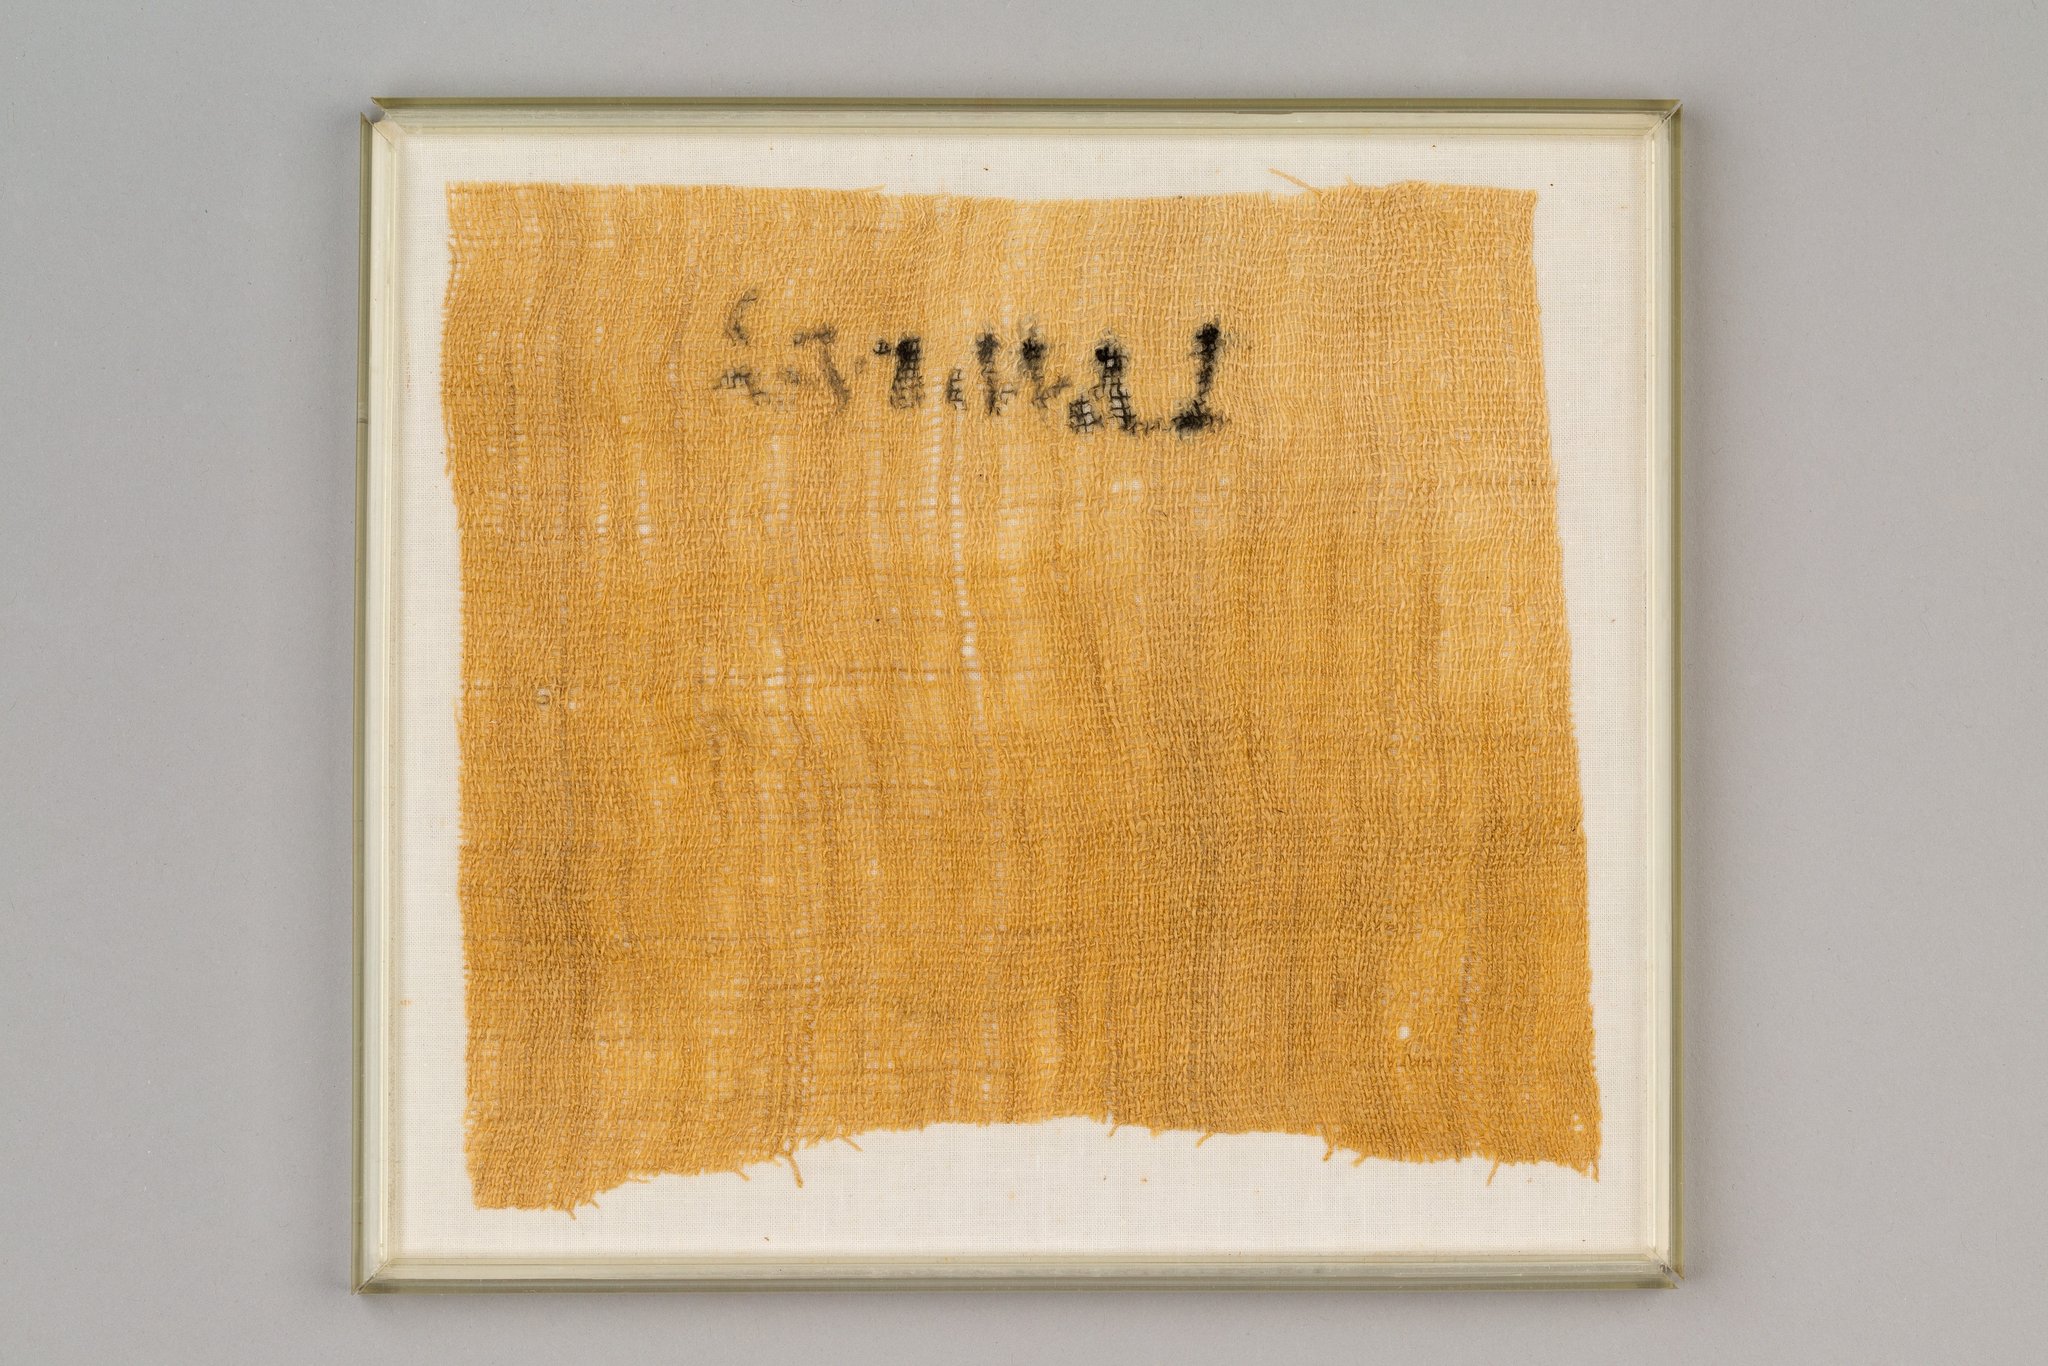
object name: linen mark, embalmer's docket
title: Embalmers' Dockets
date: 1479-1458 BCE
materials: ink, linen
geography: egypt